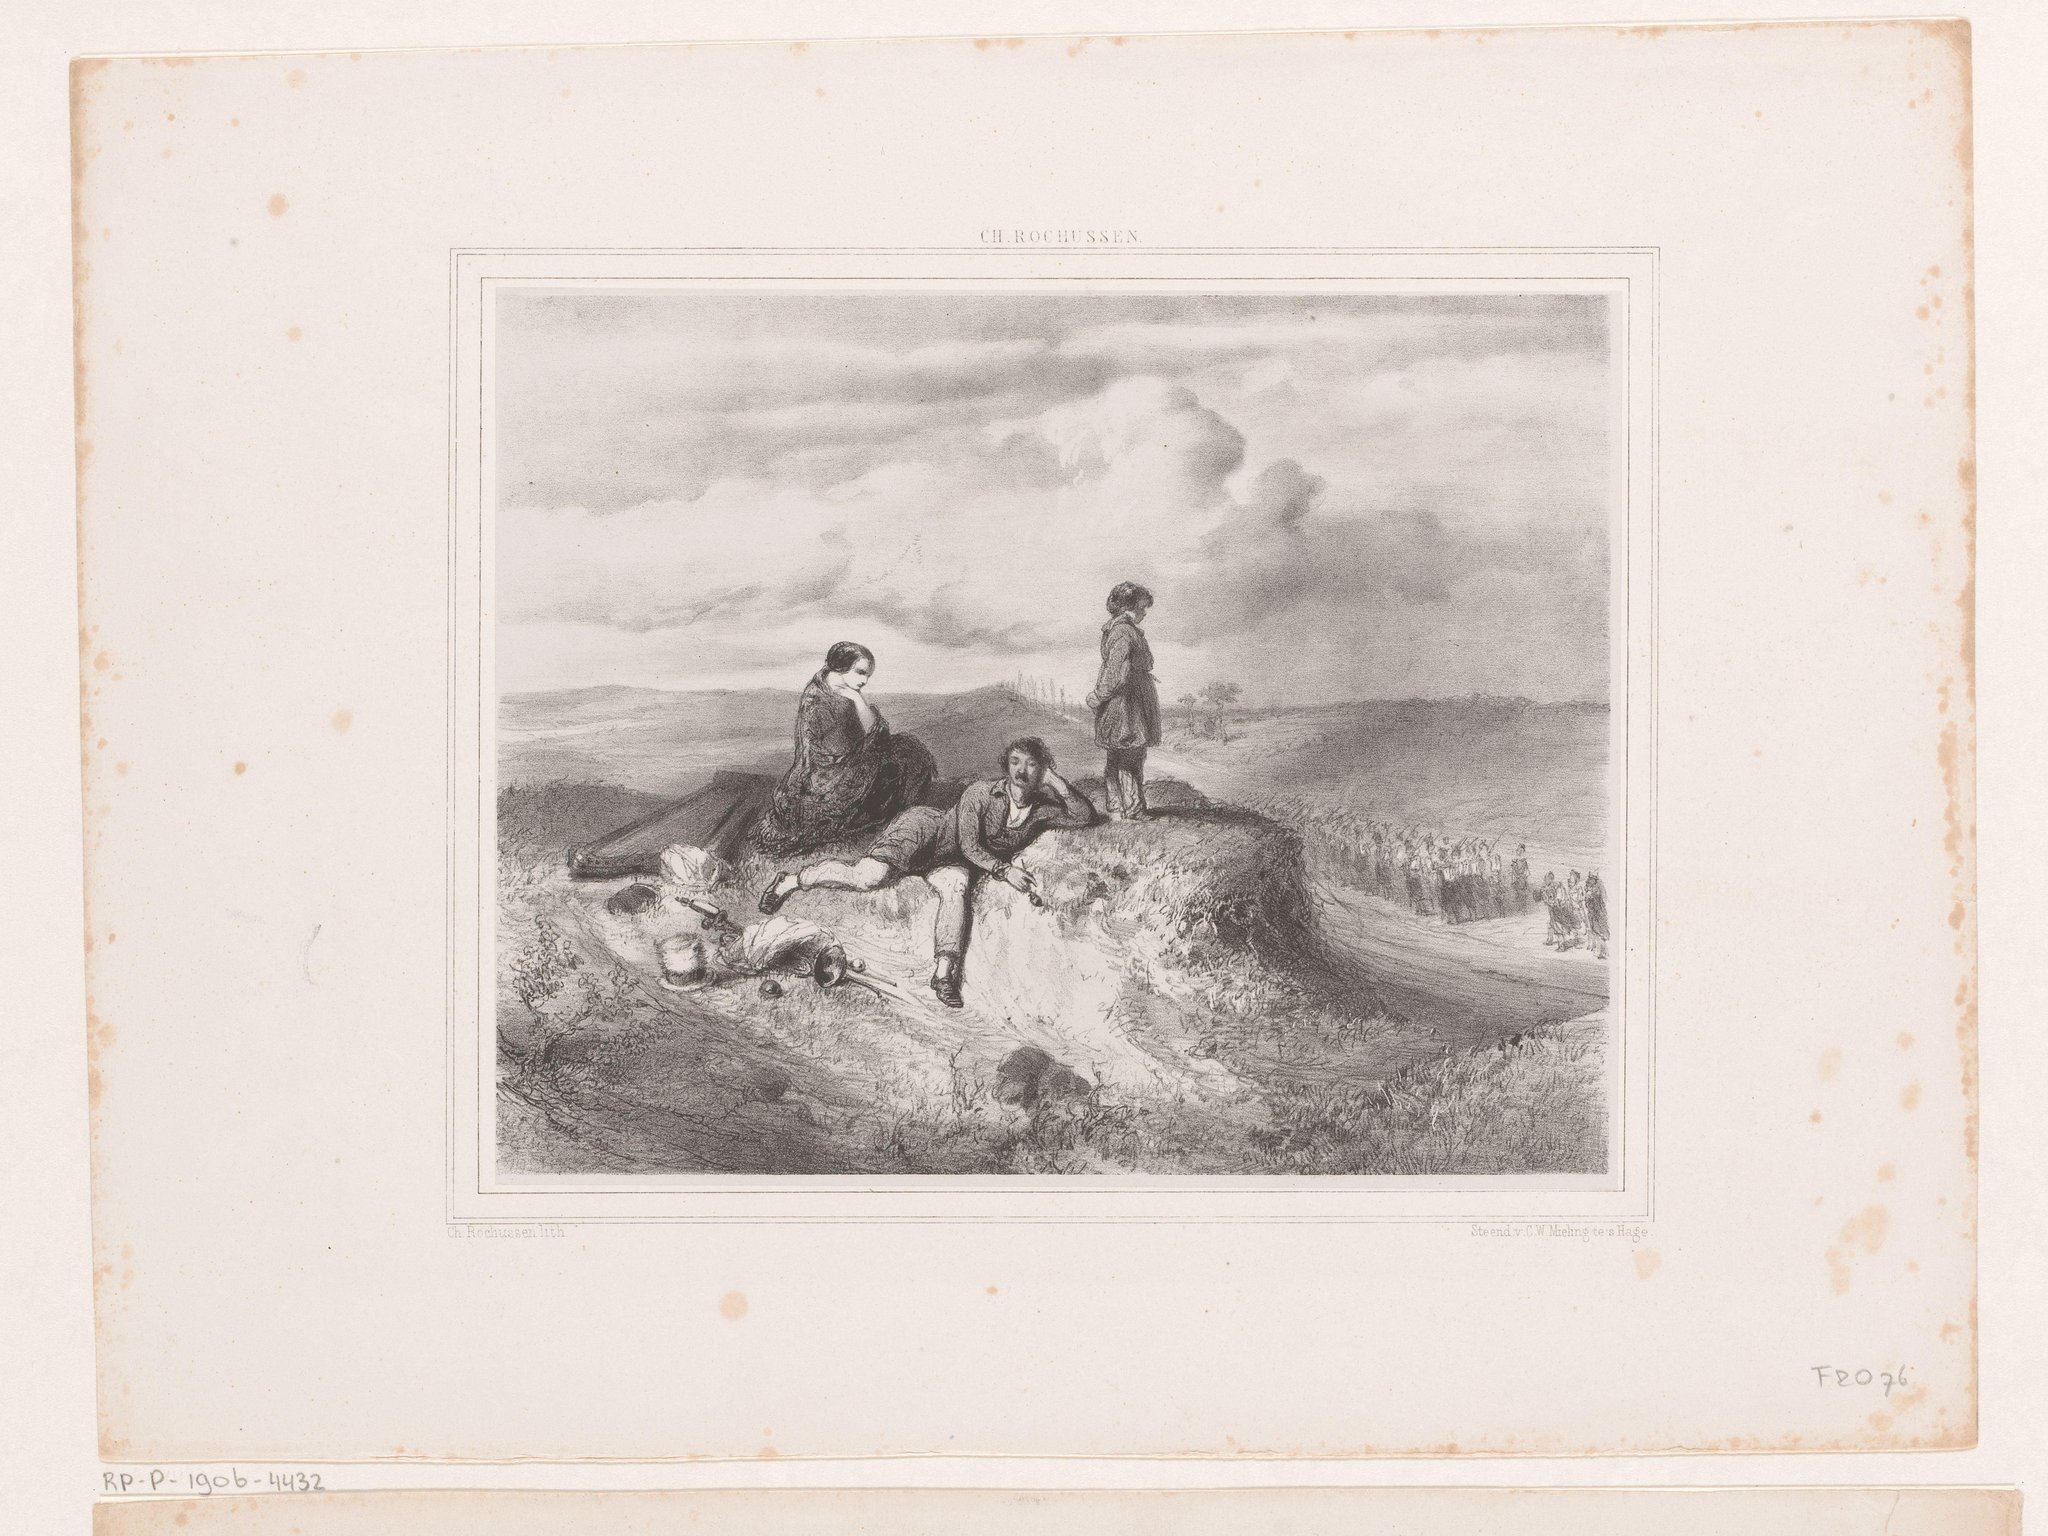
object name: print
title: Rustende man, vrouw en kind op heuvel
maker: charles rochussen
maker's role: draughtsman, painter, print maker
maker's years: 1814-1894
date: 1845-1846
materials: paper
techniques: lithograph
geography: the hague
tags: (high) hill, resting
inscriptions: collector's mark: Lugt 2228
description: Op een heuvel liggen een man en vrouw te rusten. Een kind kijkt naar een optocht onder aan de heuvel. Bij de figuren liggen een harp, goeden, trompet en sabels.